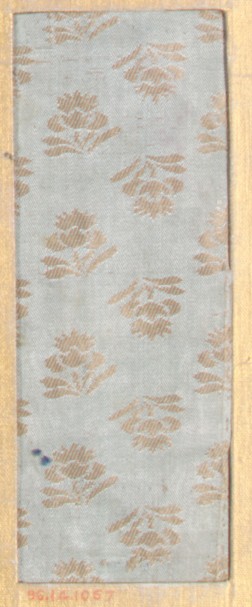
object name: piece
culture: japanese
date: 1701-1900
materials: silk